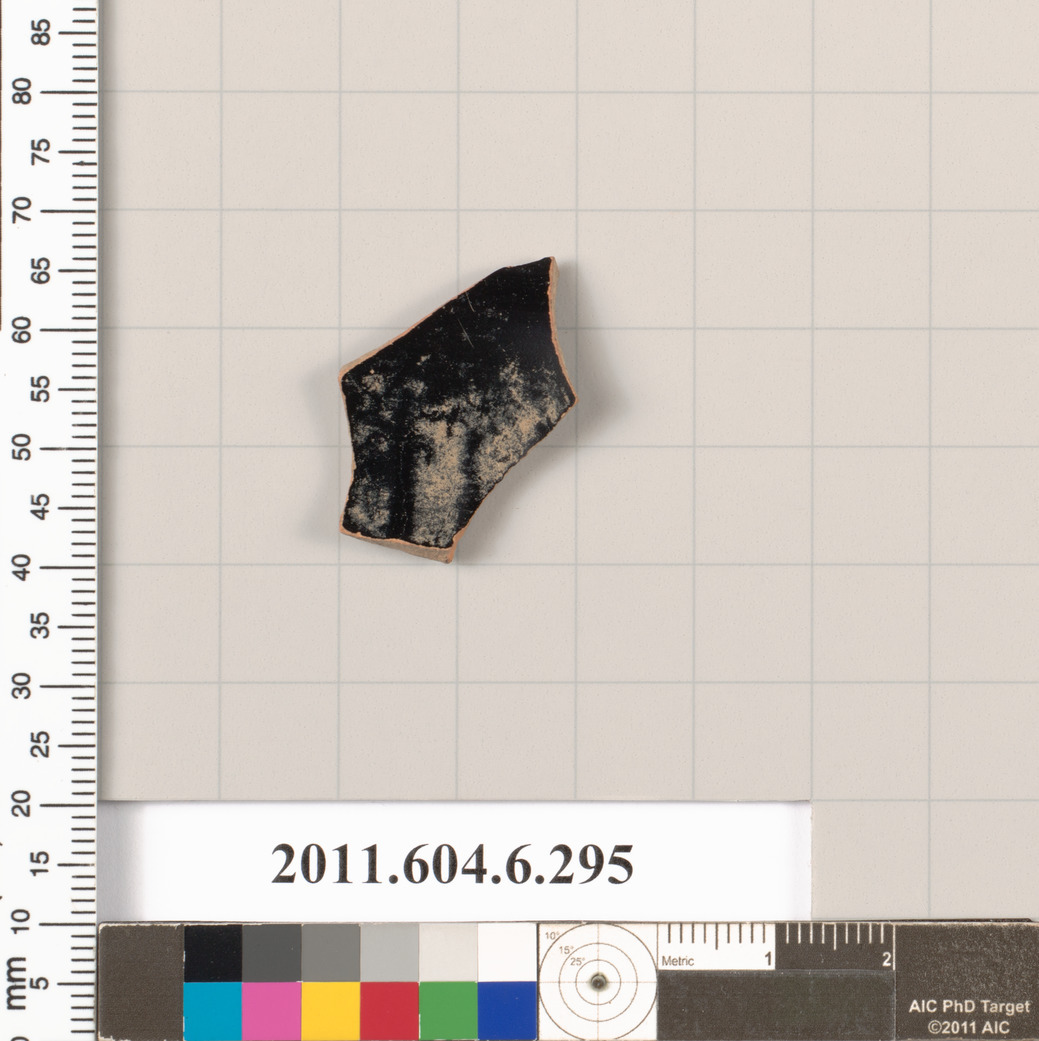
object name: undetermined open shape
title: Terracotta fragment of an open shape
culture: greek, attic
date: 367-335 BCE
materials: terracotta